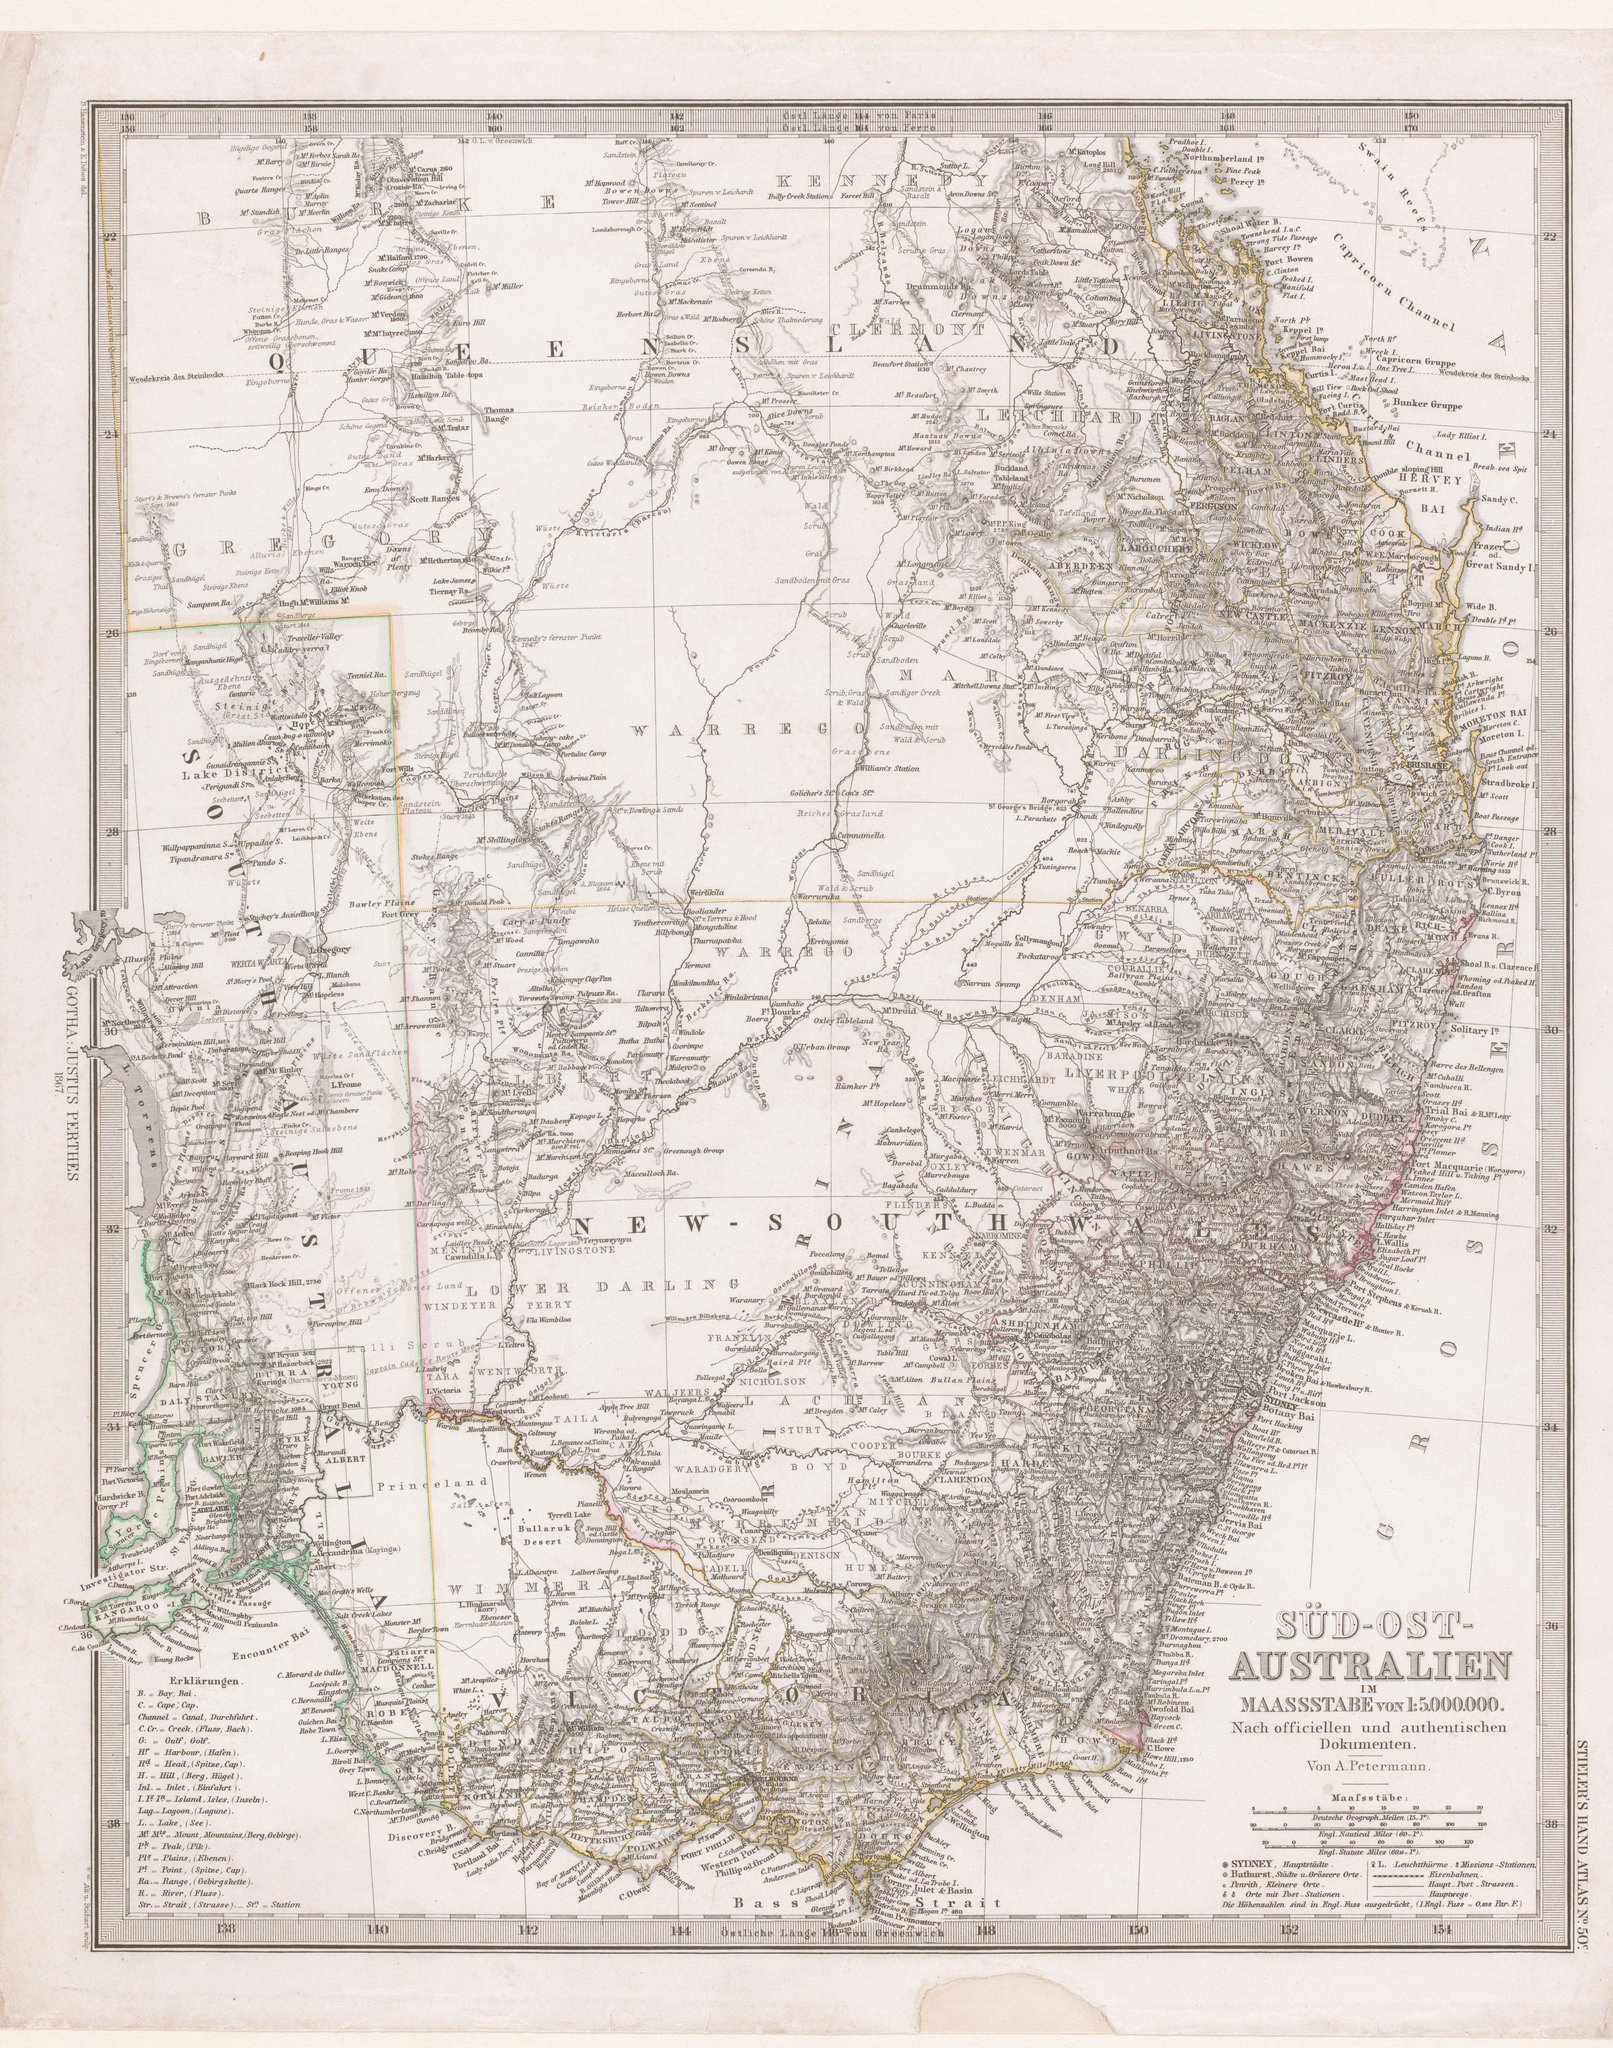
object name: map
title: Süd-ost-Australien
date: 1867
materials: paper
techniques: engraving, etching, hand coloring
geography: gotha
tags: maps, atlases, australia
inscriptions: collector's mark: Lugt 2228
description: Prent uit: Stielers Handatlas. Gotha: Uitgeverij Justus Perthes, 1867, dl. 5.